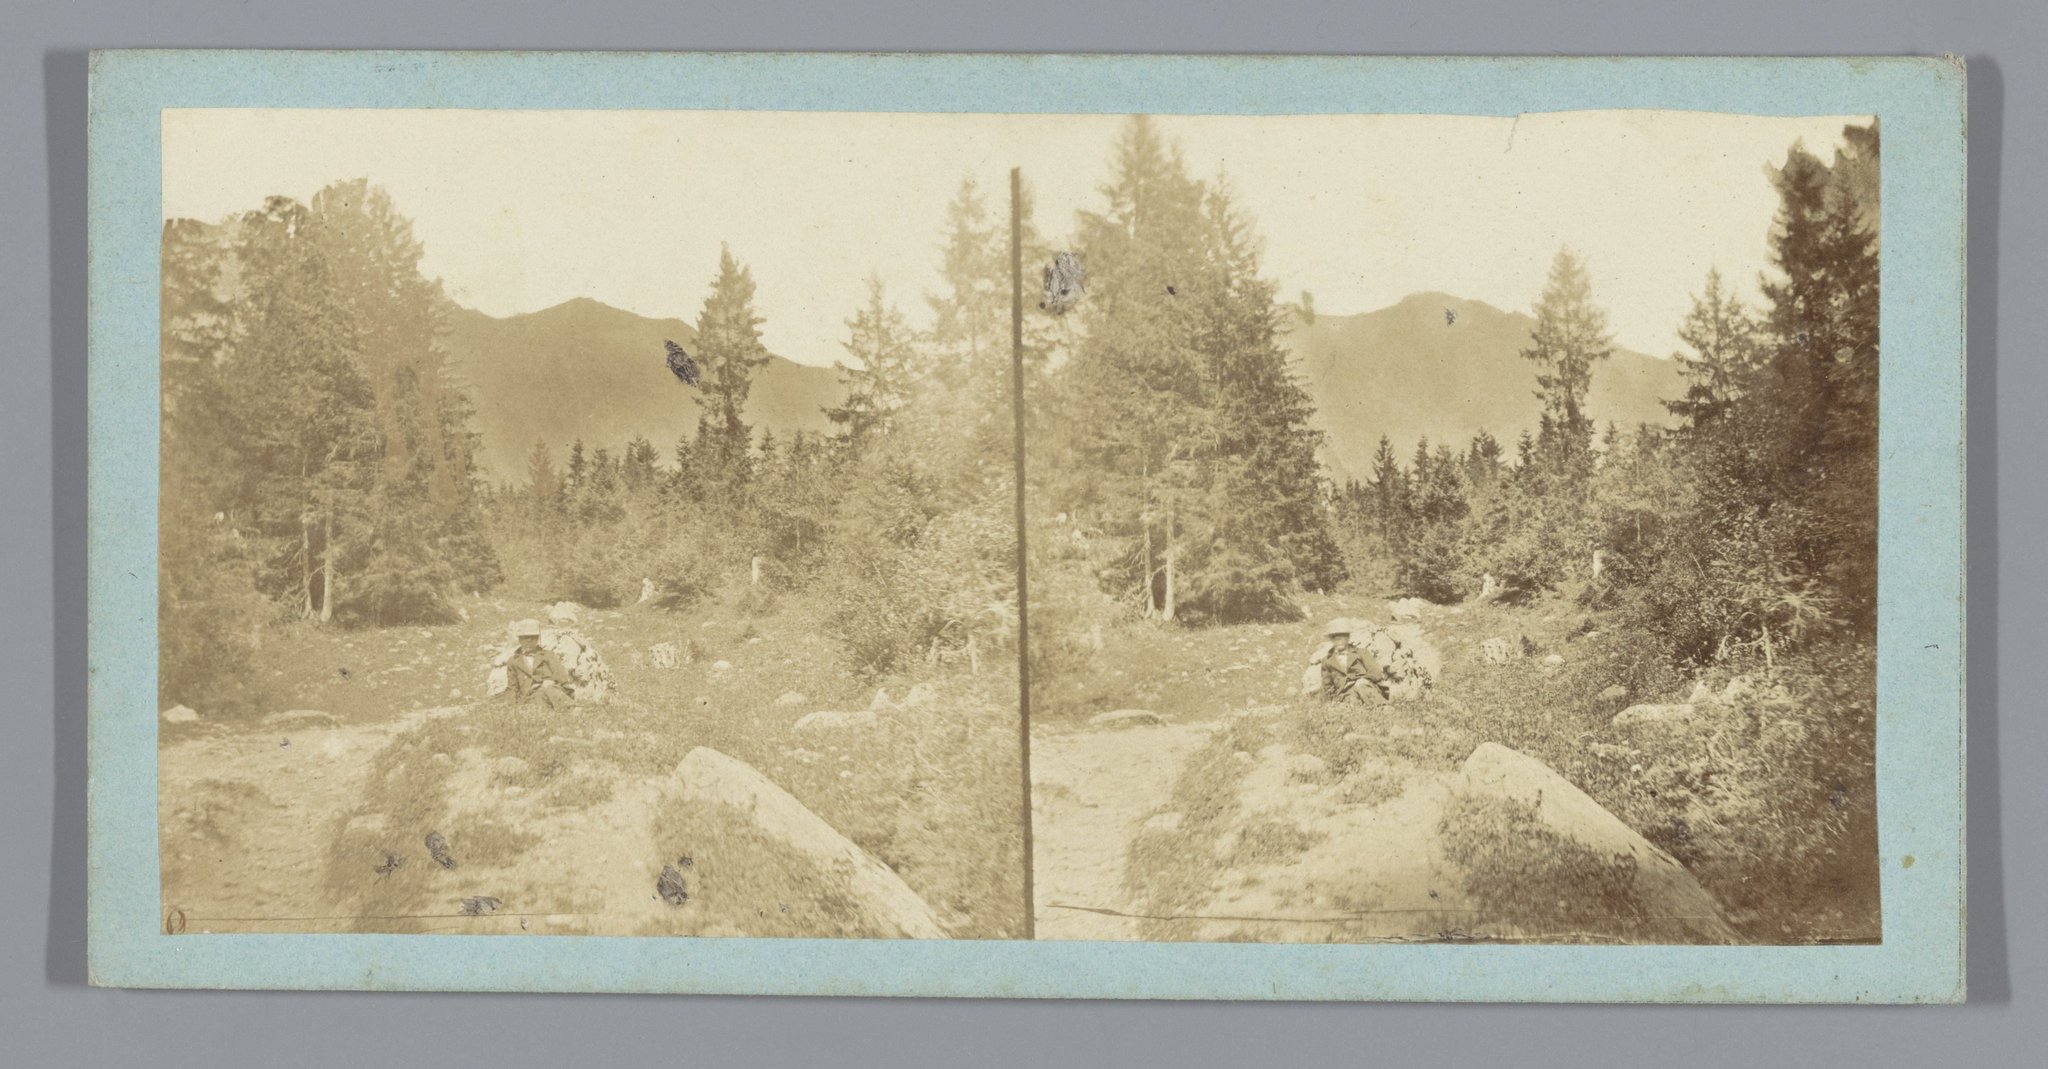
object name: stereograph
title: Gezicht op de Combe de Savoie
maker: Anonymous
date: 1860-1880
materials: cardboard, photographic support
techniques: albumen print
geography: savoie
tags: dale, valley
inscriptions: inscription: ‘Vue prise au fond de la Combe, Savoie’, number: ‘No 80’